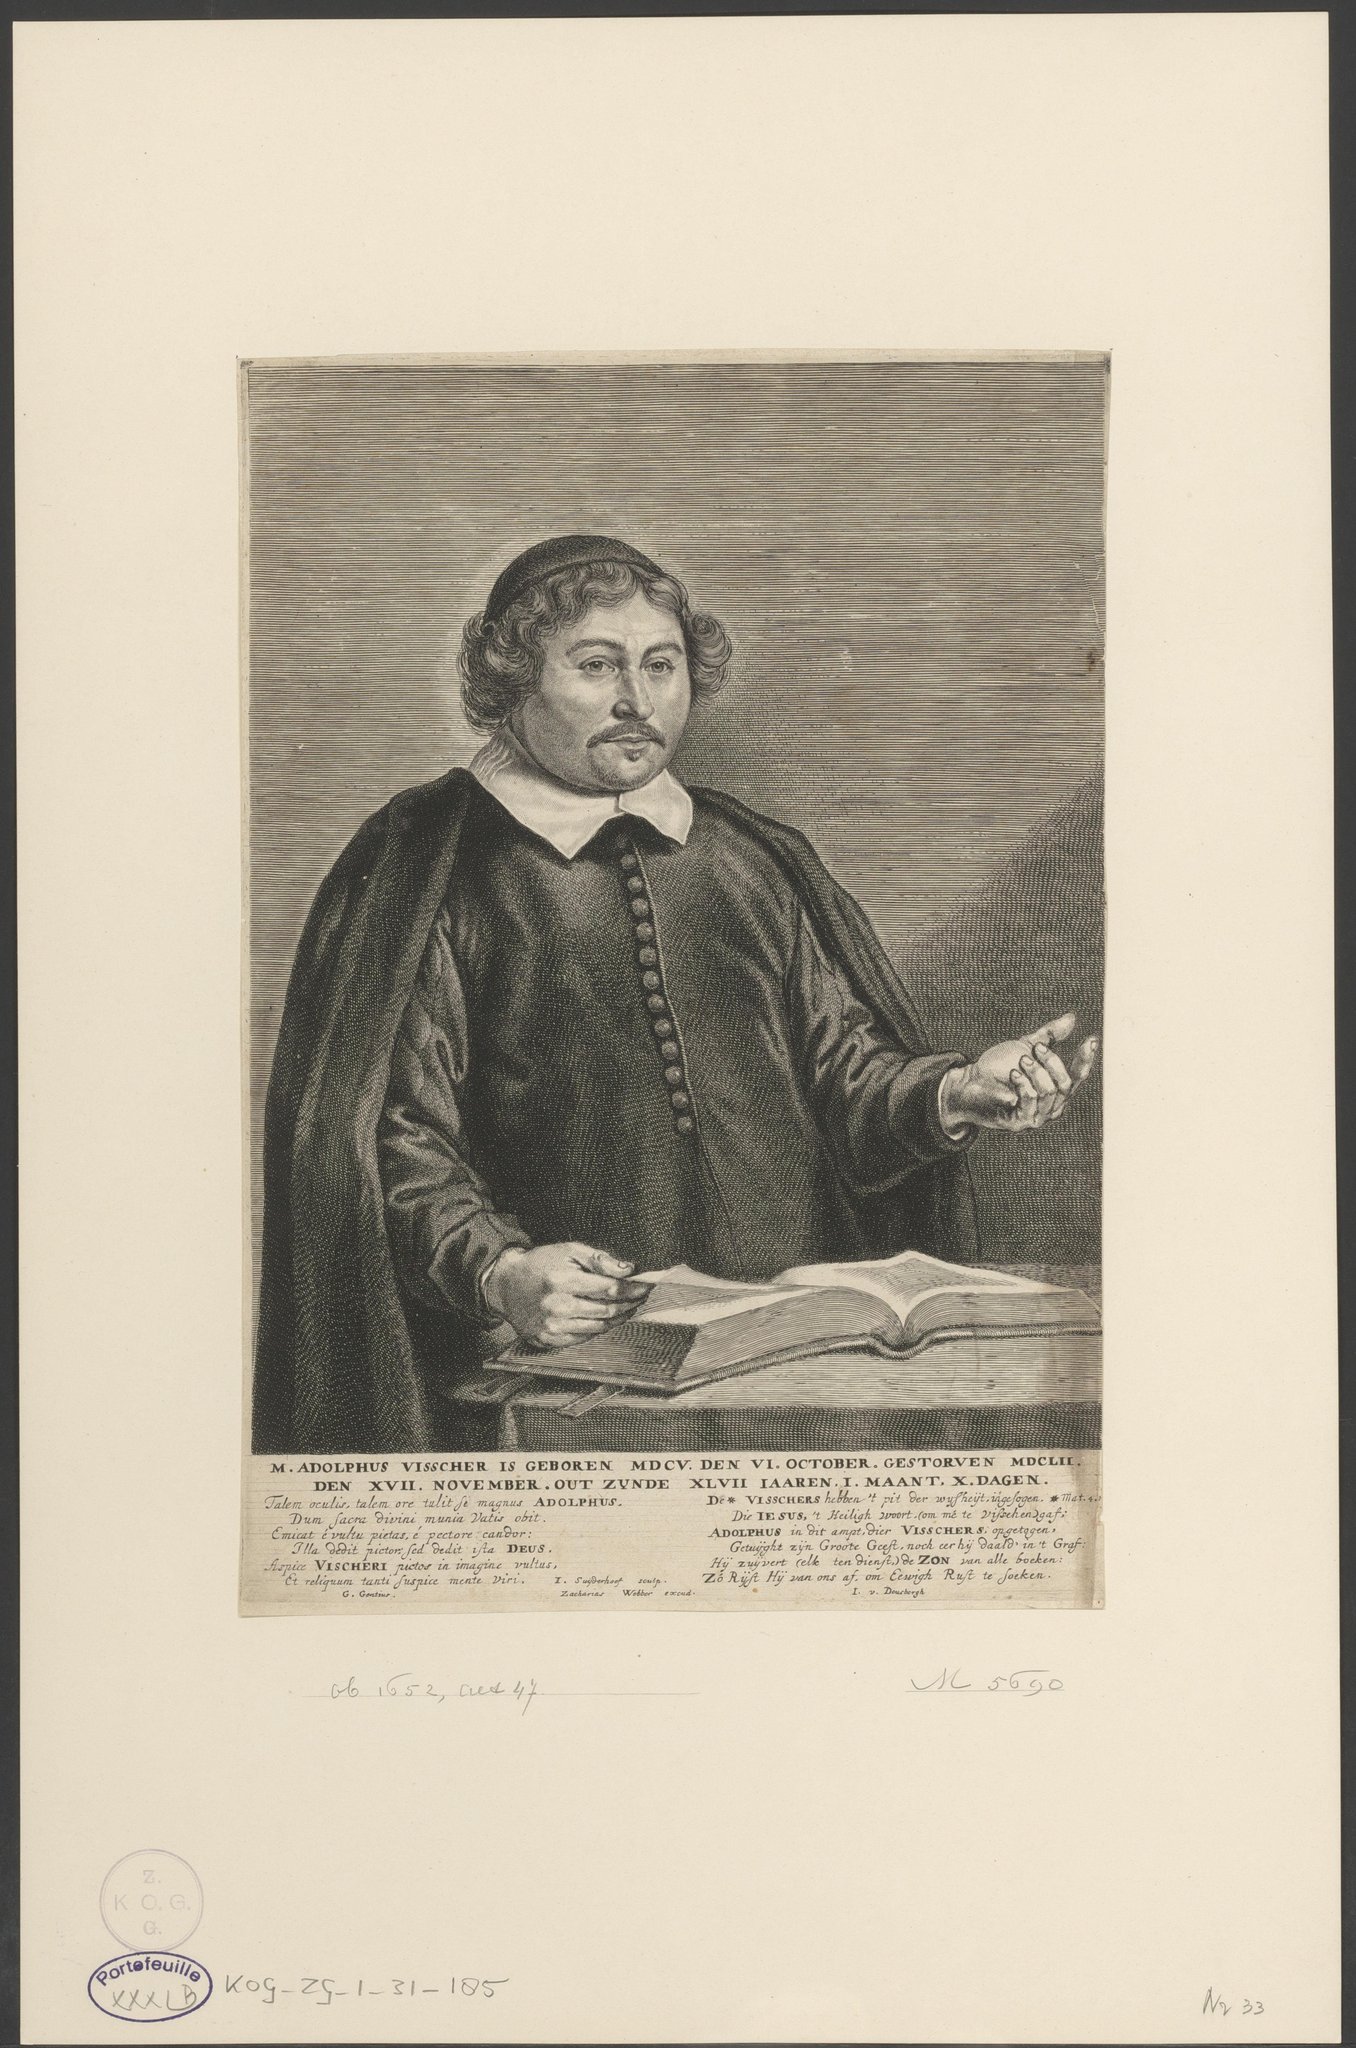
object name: print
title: Portret van Adolf Visscher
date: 1652-1702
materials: paper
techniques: engraving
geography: amsterdam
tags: amsterdam, adolf visscher (1605-1652), historical persons, the bible as a book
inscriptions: stamp, collector's mark: Lugt 1641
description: Portret van Adolf Visscher, predikant te Amsterdam, staand achter een tafel bij een open bijbel. Onder het portret een zesregelig vers in het Latijn en het Nederlands. Onderwerpsrubrieken binnen de Atlas Zeden en Gewoonten: Portretten, Portretten van bijzondere personen.